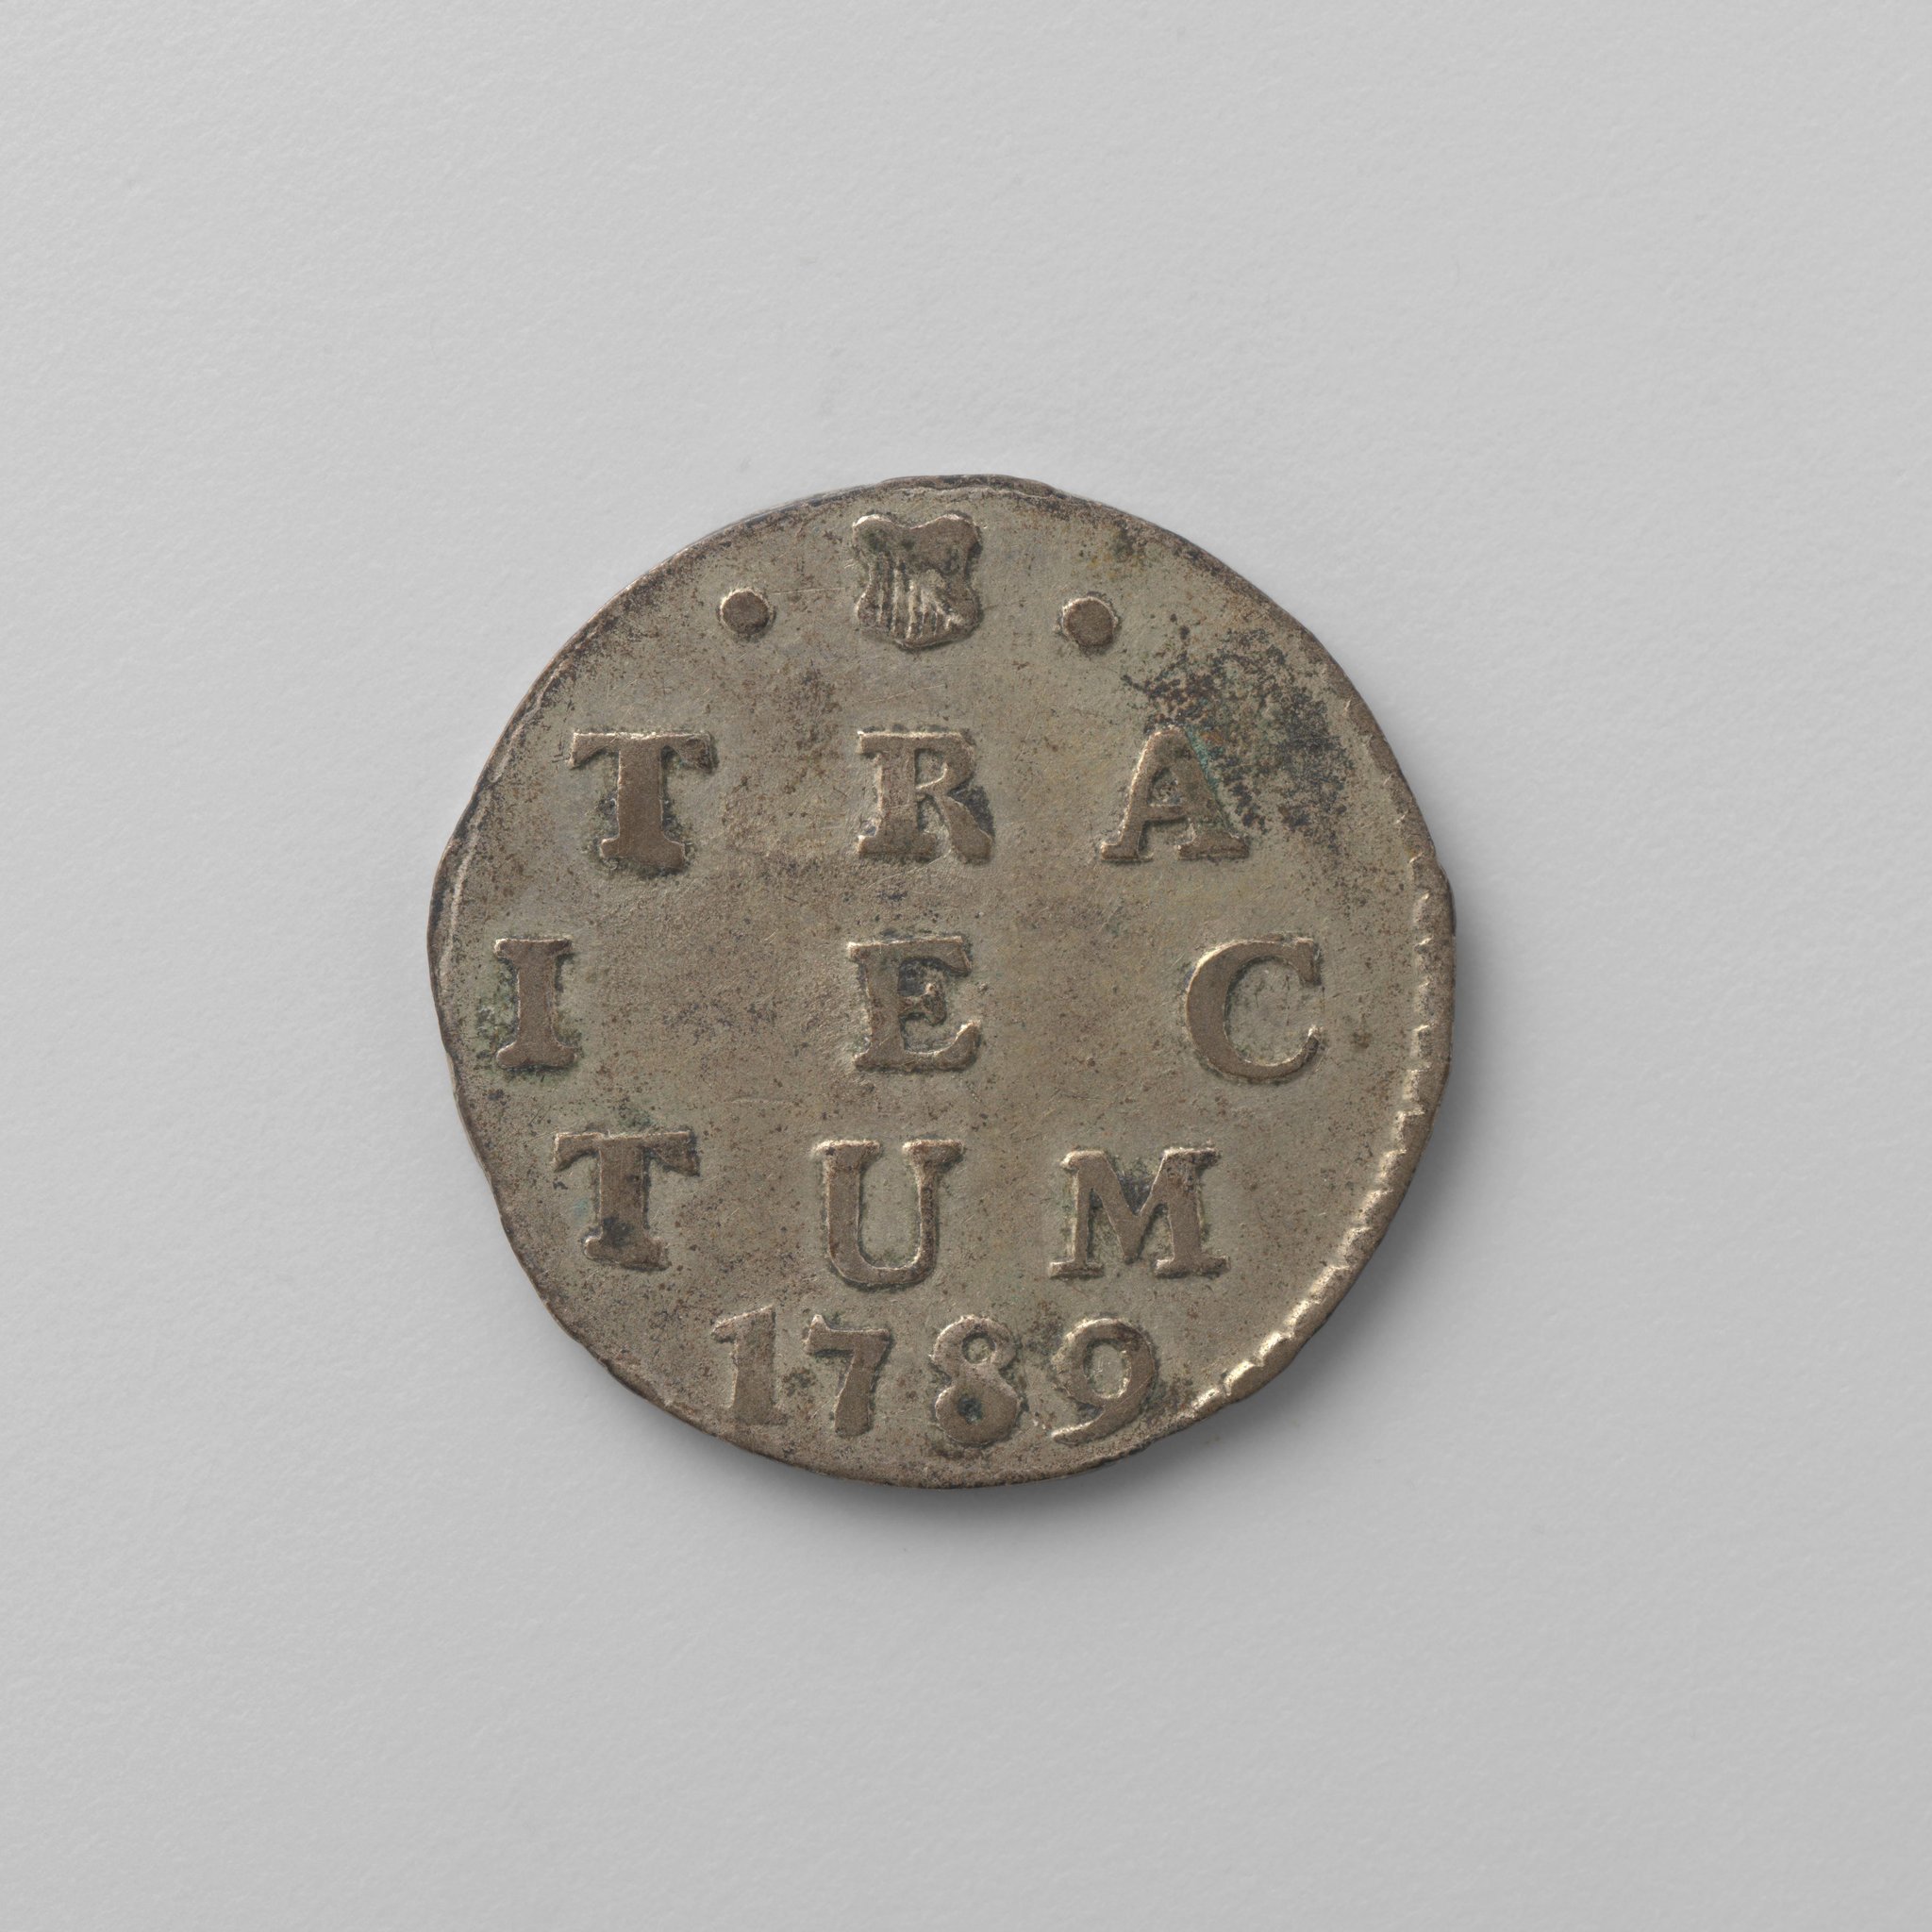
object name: coin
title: Utrechtse dubbele stuiver, 1789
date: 1789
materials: silver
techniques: striking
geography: utrecht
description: Zilveren munt. Voorzijde: tussen waarde-aanduiding 2 S gekroond enkelveldig wapenschild van Utrecht. Keerzijde: onder muntteken tussen twee puntjes opschrift: provincienaam in drie regels, daaronder jaartal. Gladde rand.